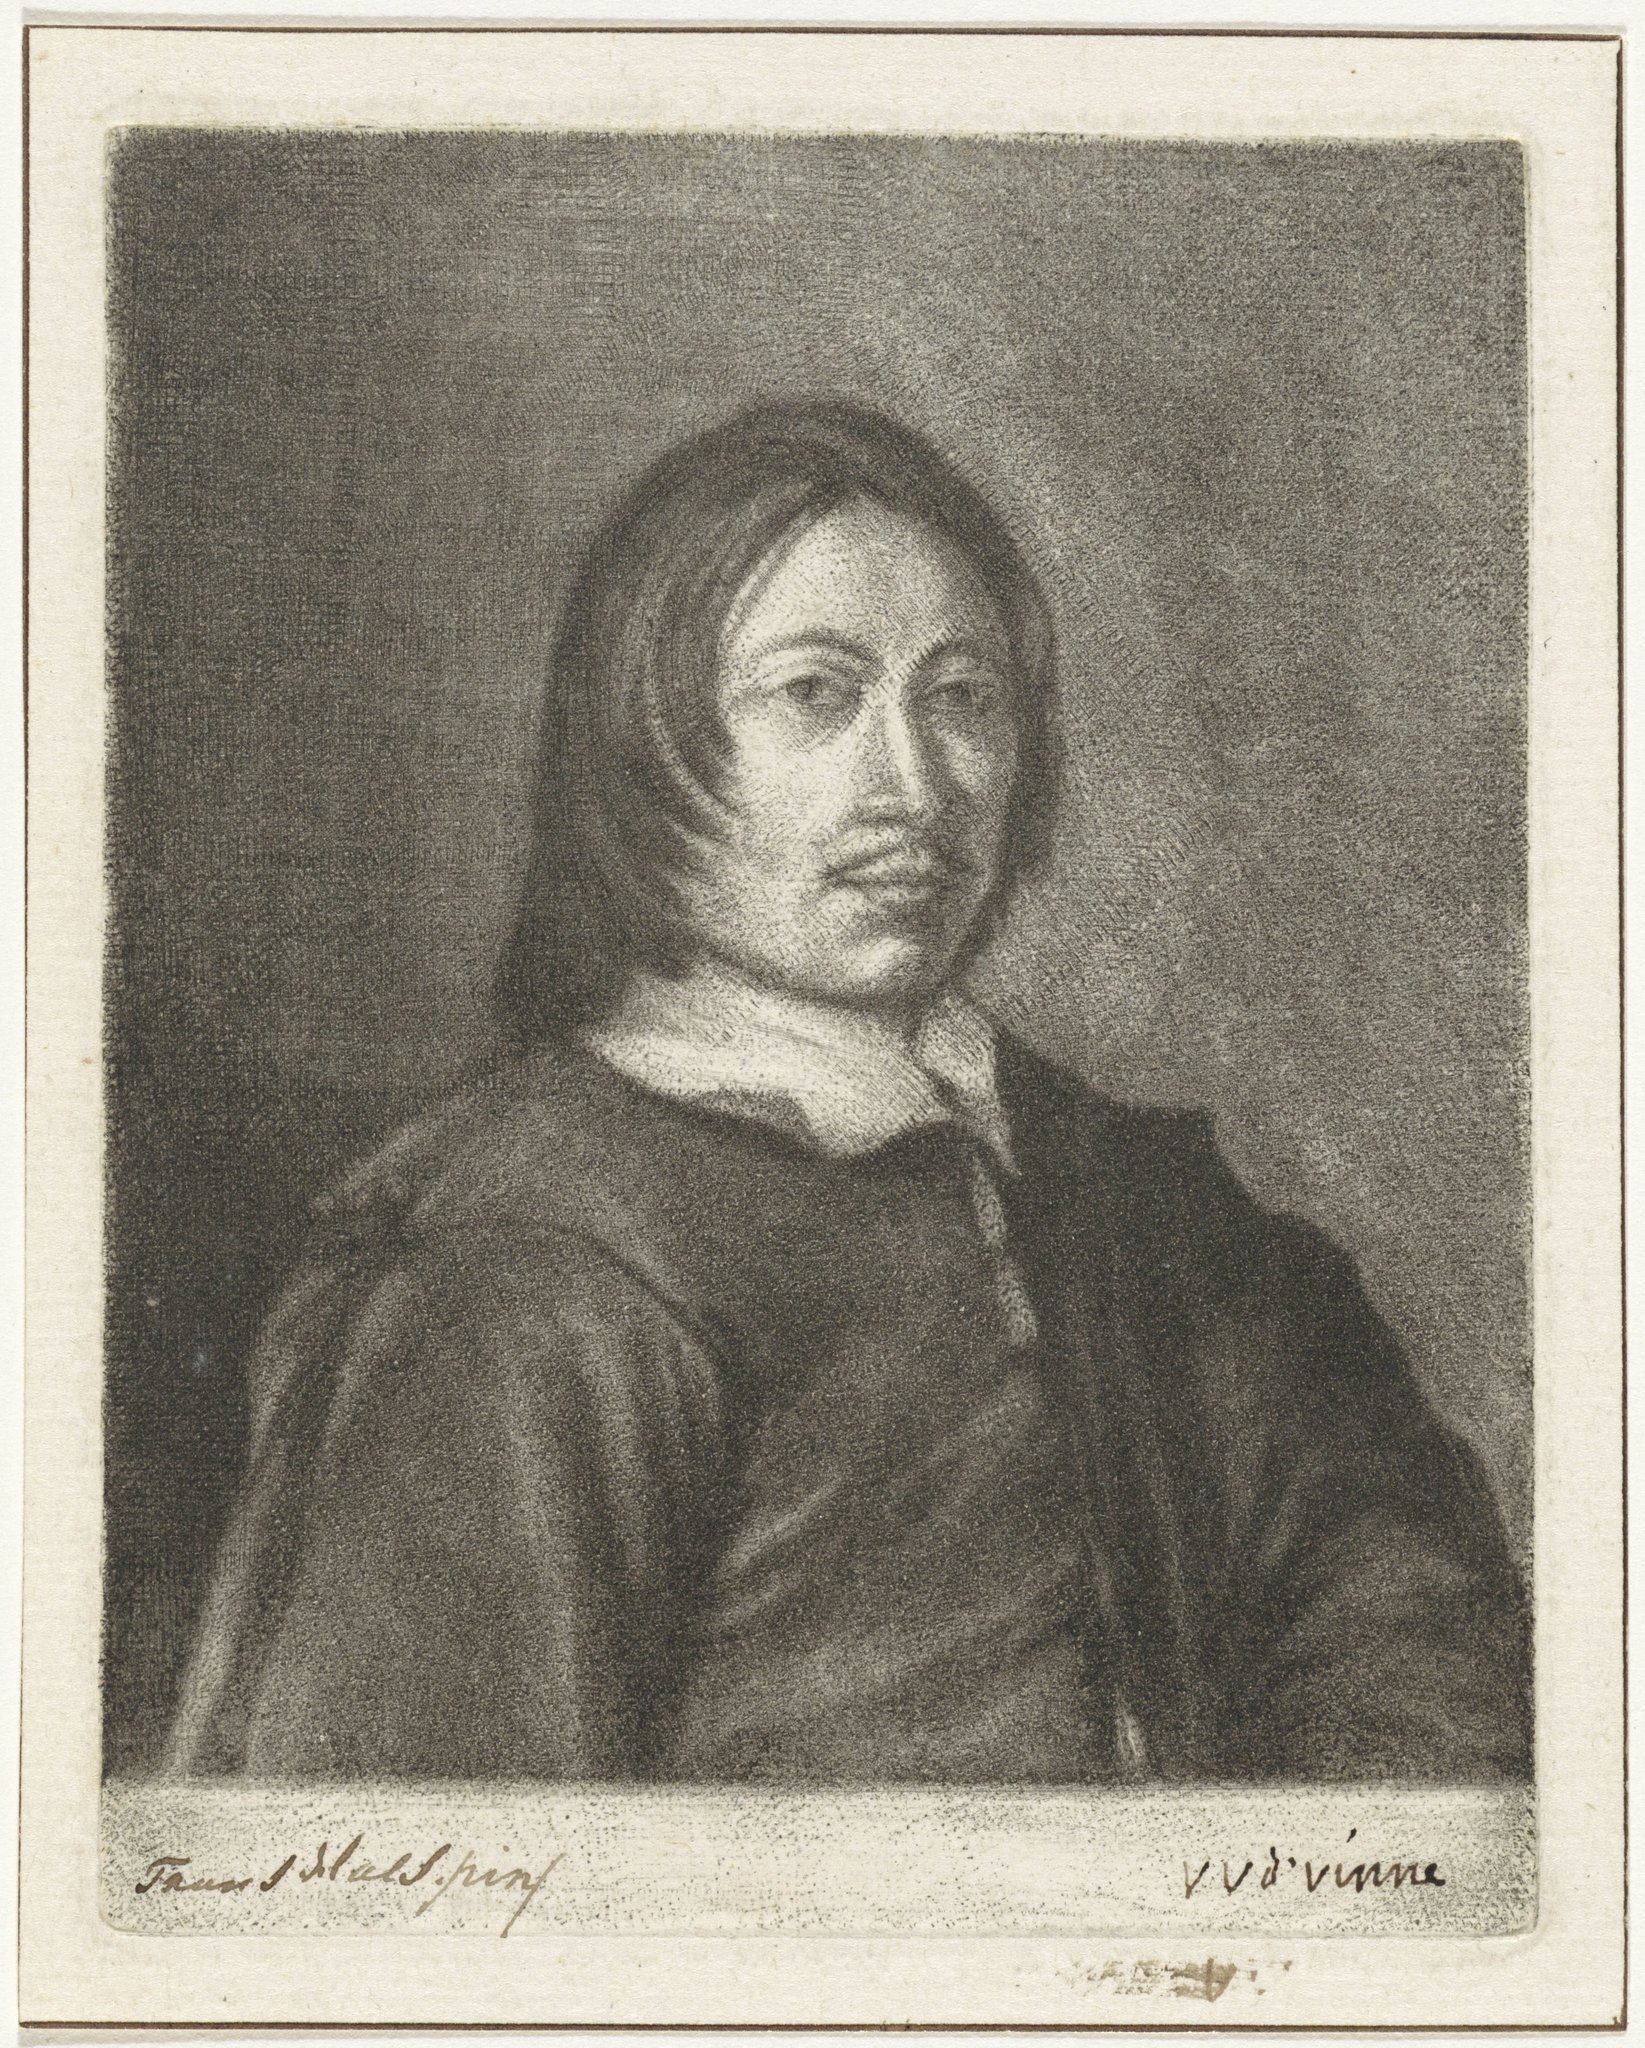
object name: print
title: Portret van Vincent Laurensz. van der Vinne I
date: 1696-1742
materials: paper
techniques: mezzotint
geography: haarlem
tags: haarlem, vincent laurensz. van der vinne (i), portrait, self-portrait of artist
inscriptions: collector's mark: Lugt 2228, inscription: ‘Frans Hals pinf V V d'Vinne’